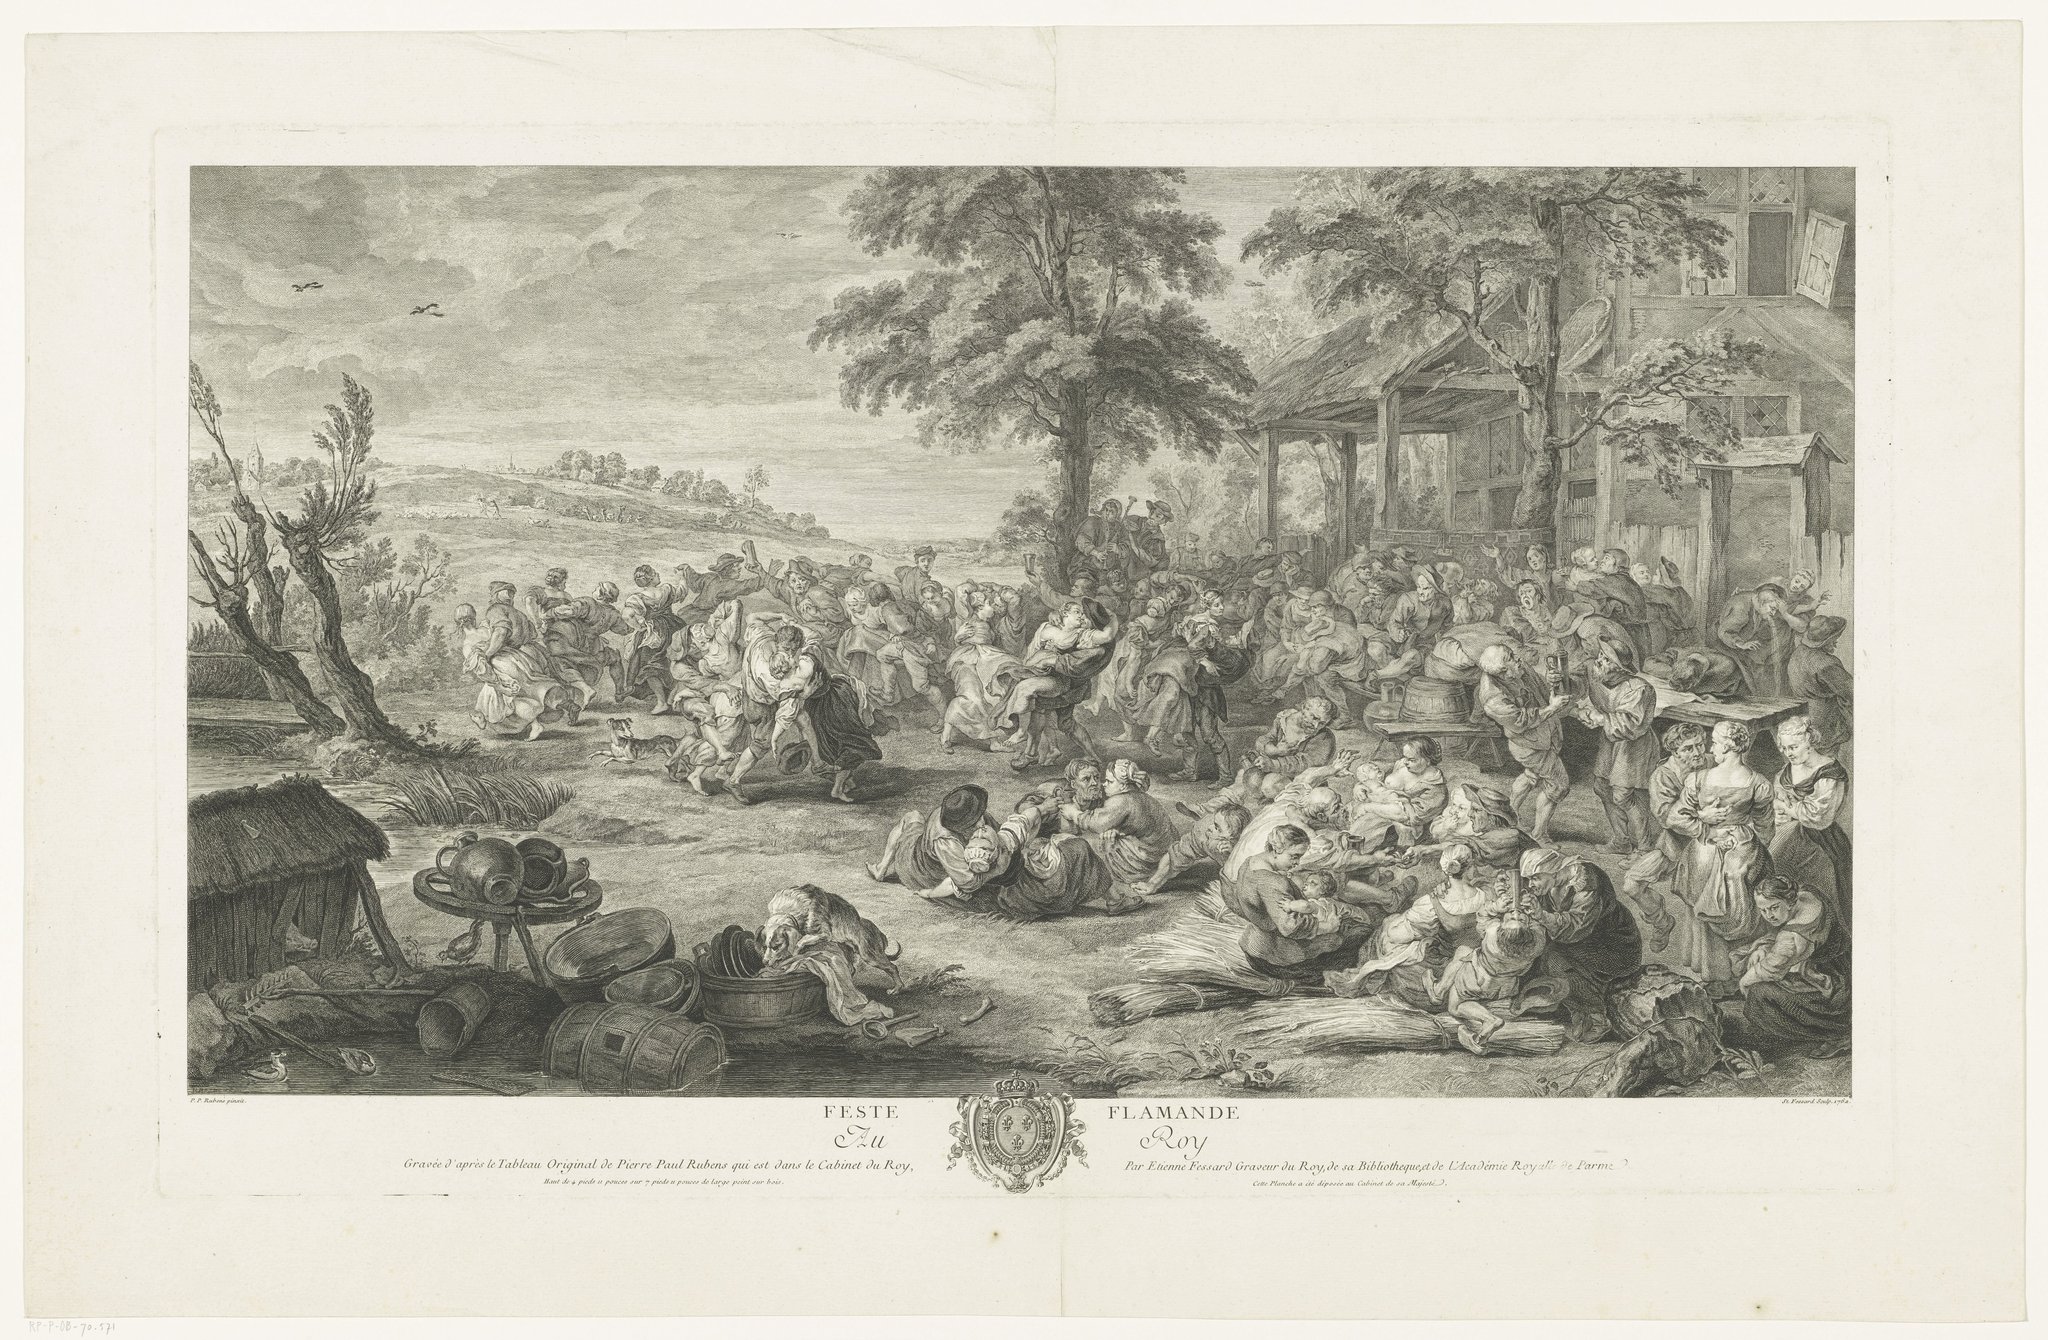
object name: print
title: Feste Flamande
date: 1762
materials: paper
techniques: engraving, etching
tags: public festivities, armorial bearing, heraldry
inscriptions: collector's mark: Lugt 240